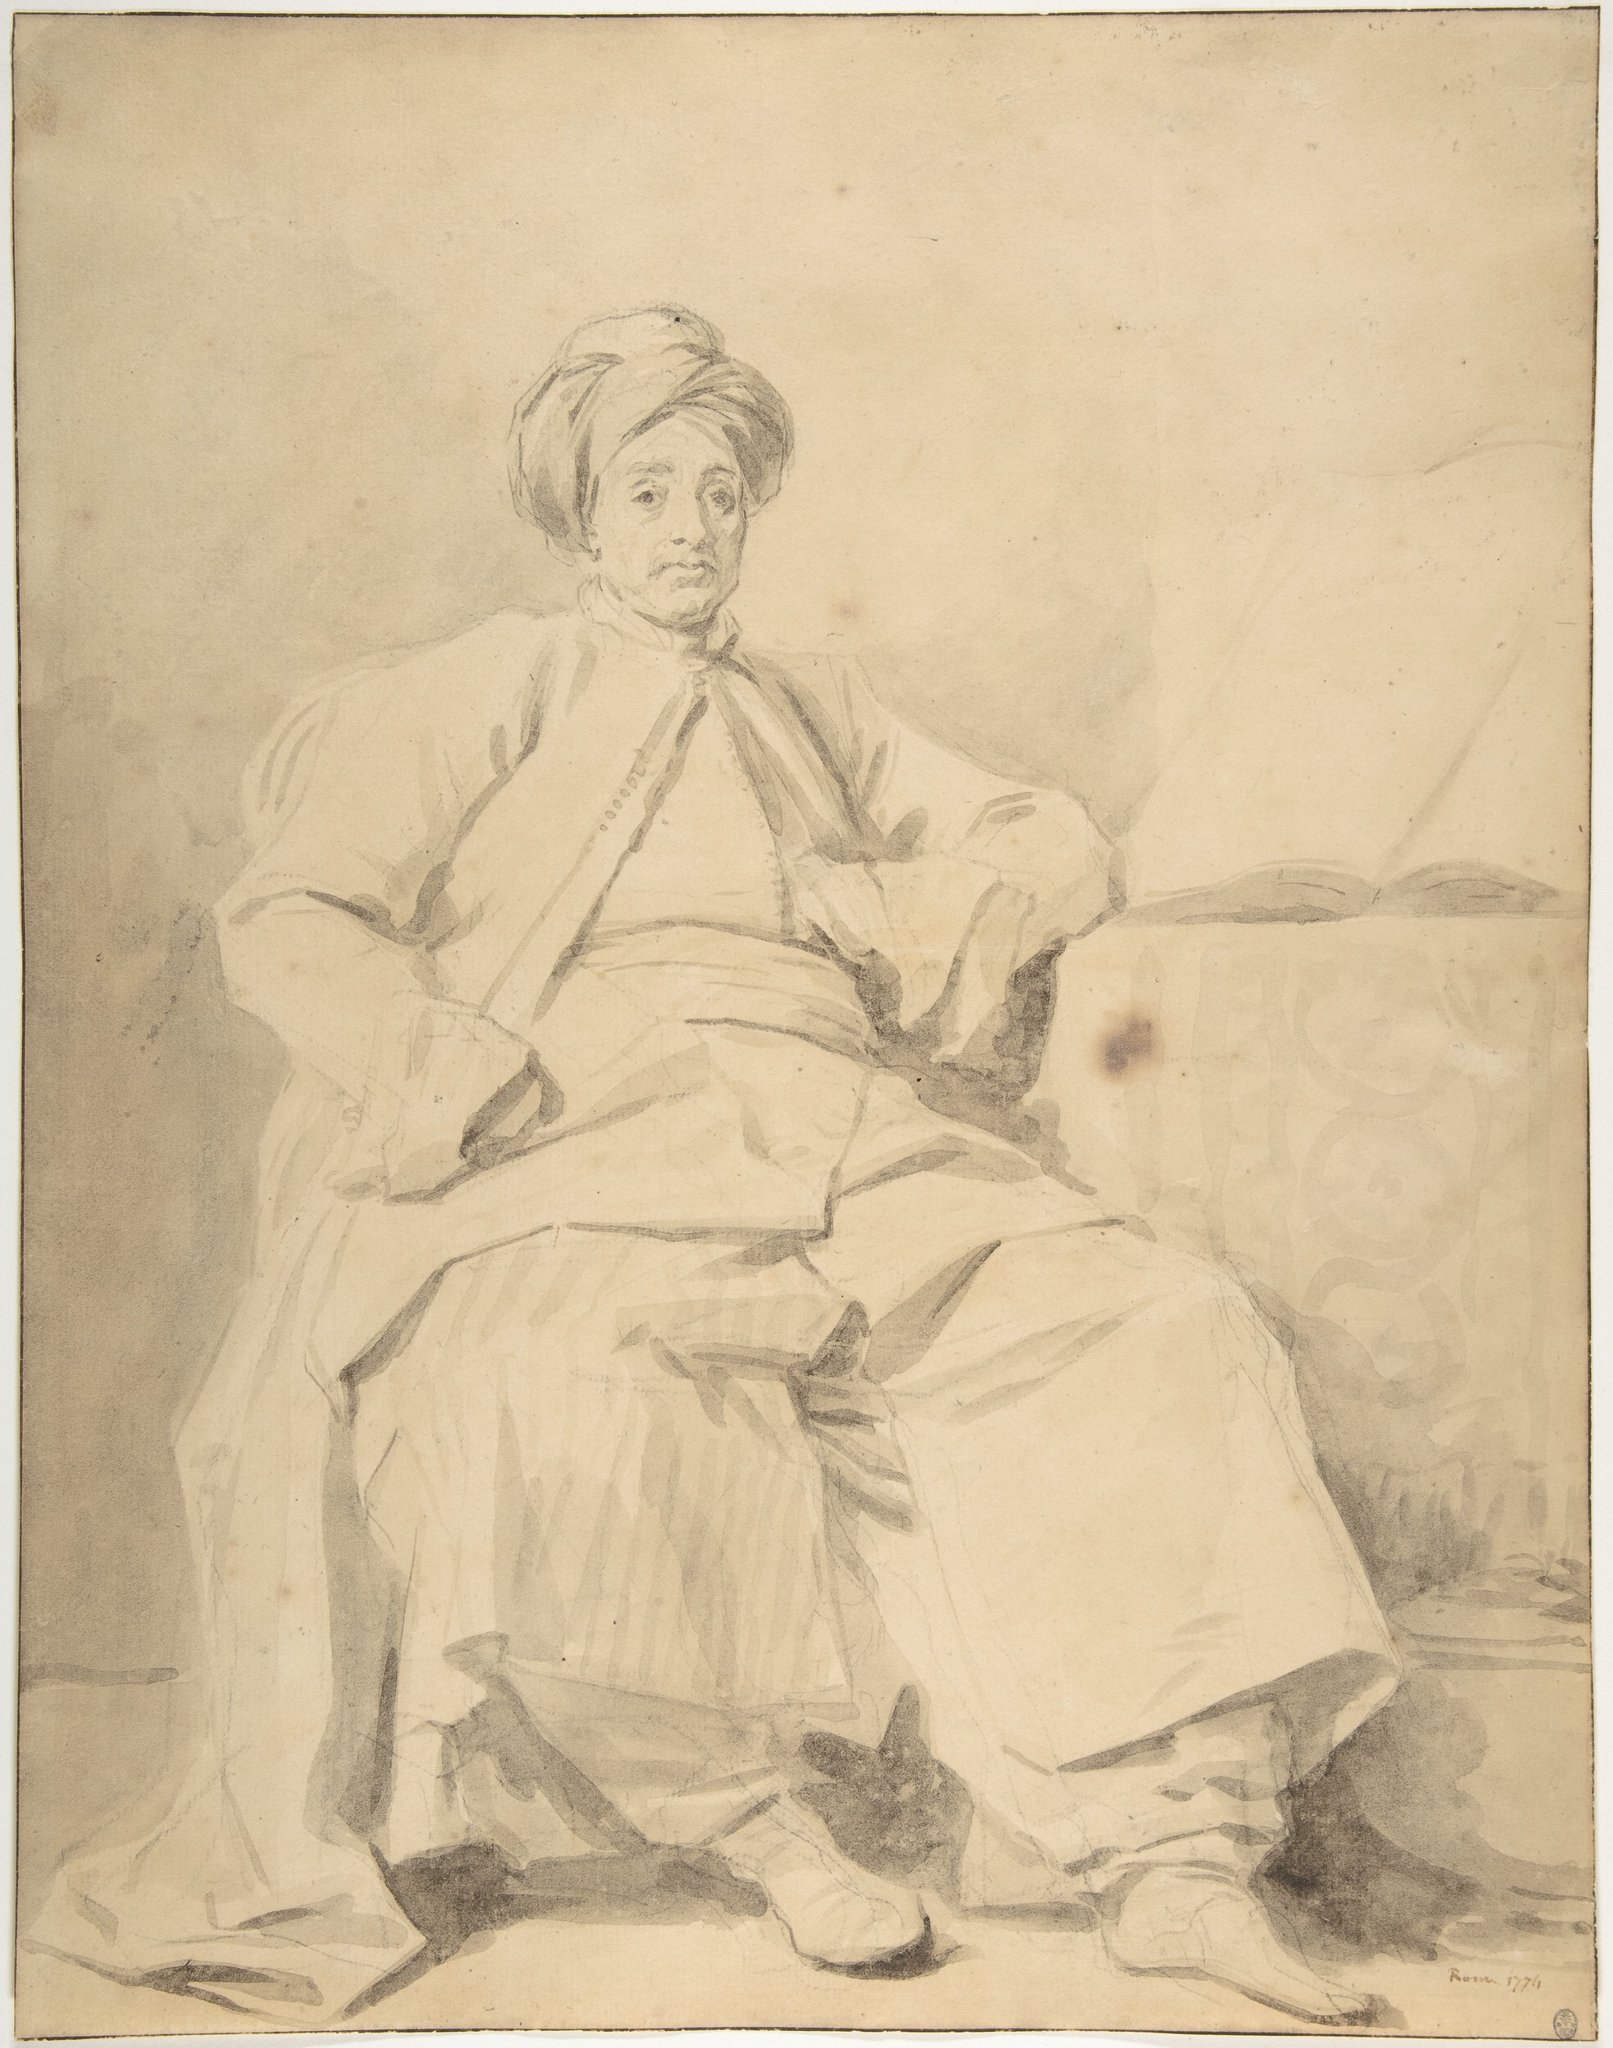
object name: drawing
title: The Sultan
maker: jean honoré fragonard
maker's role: artist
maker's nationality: french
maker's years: 1732-1806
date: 1774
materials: chalk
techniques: brush, drawing, wash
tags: men